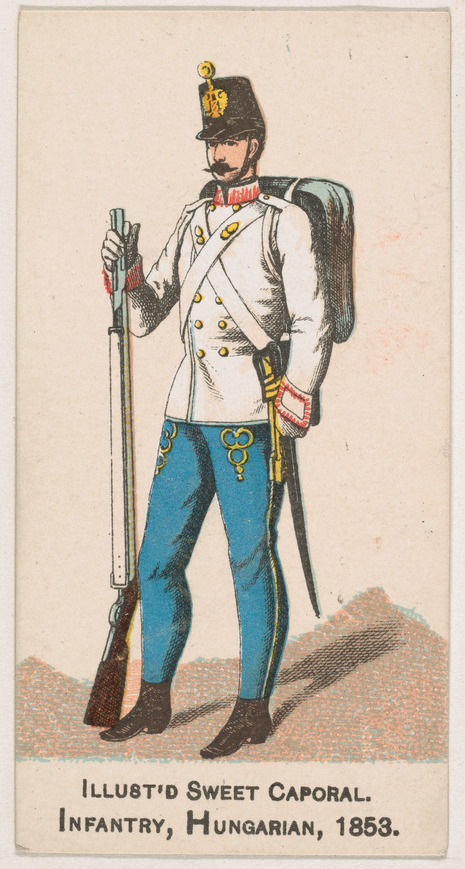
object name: print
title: Infantry, Hungarian, 1853, from the Military Series (N224) issued by Kinney Tobacco Company to promote Sweet Caporal Cigarettes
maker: kinney brothers tobacco company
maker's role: publisher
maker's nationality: american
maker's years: 1869-2011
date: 1888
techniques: color lithograph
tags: military,men